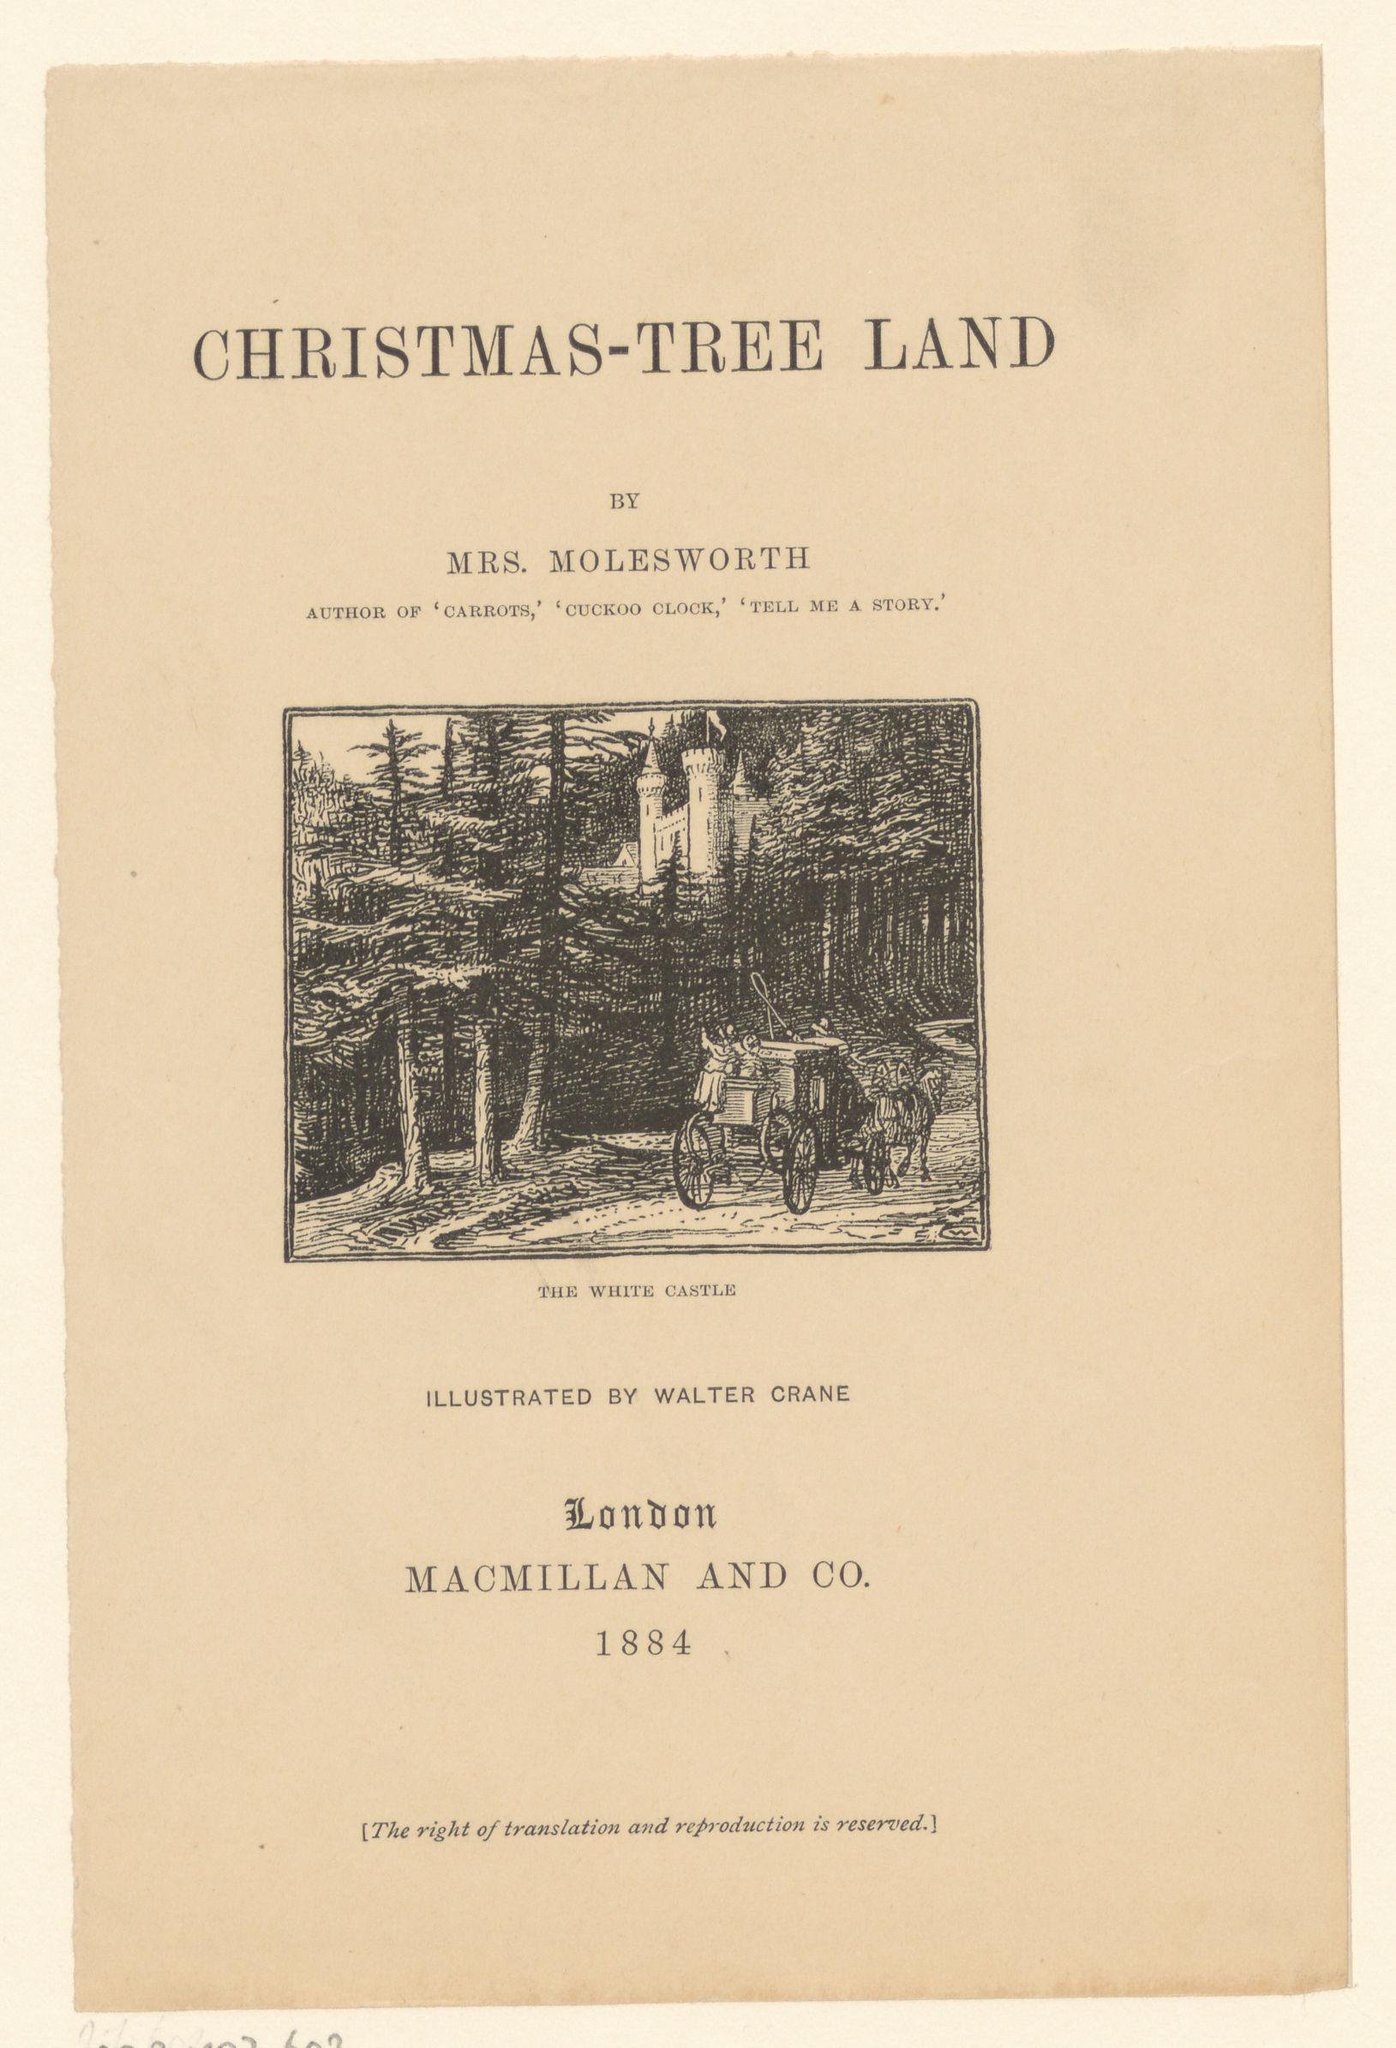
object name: titelblad, titelpagina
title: Titelpagina voor: Molesworth, Christmas-tree land, 1884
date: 1884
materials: paper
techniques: letterpress printing, engraving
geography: london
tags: four-wheeled vehicle drawn by one animal, forest, wood, landscape with tower or castle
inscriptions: collector's mark: Lugt 2228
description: Titelpagina voor: Molesworth, Mary Louisa. Christmas-Tree land. Londen: Macmillan & Co., 1884.